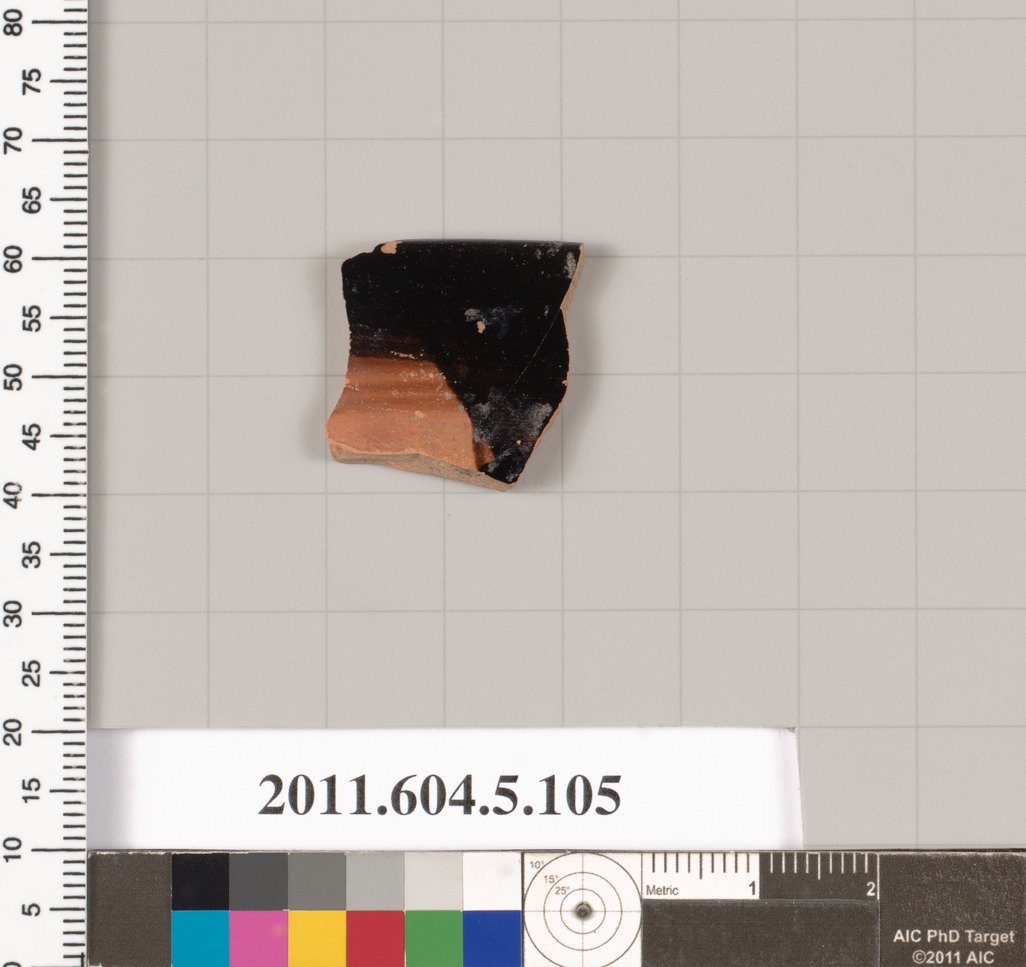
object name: kylix fragment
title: Terracotta rim fragment of a stemless kylix(drinking cup)?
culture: greek, attic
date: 470-450 BCE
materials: terracotta